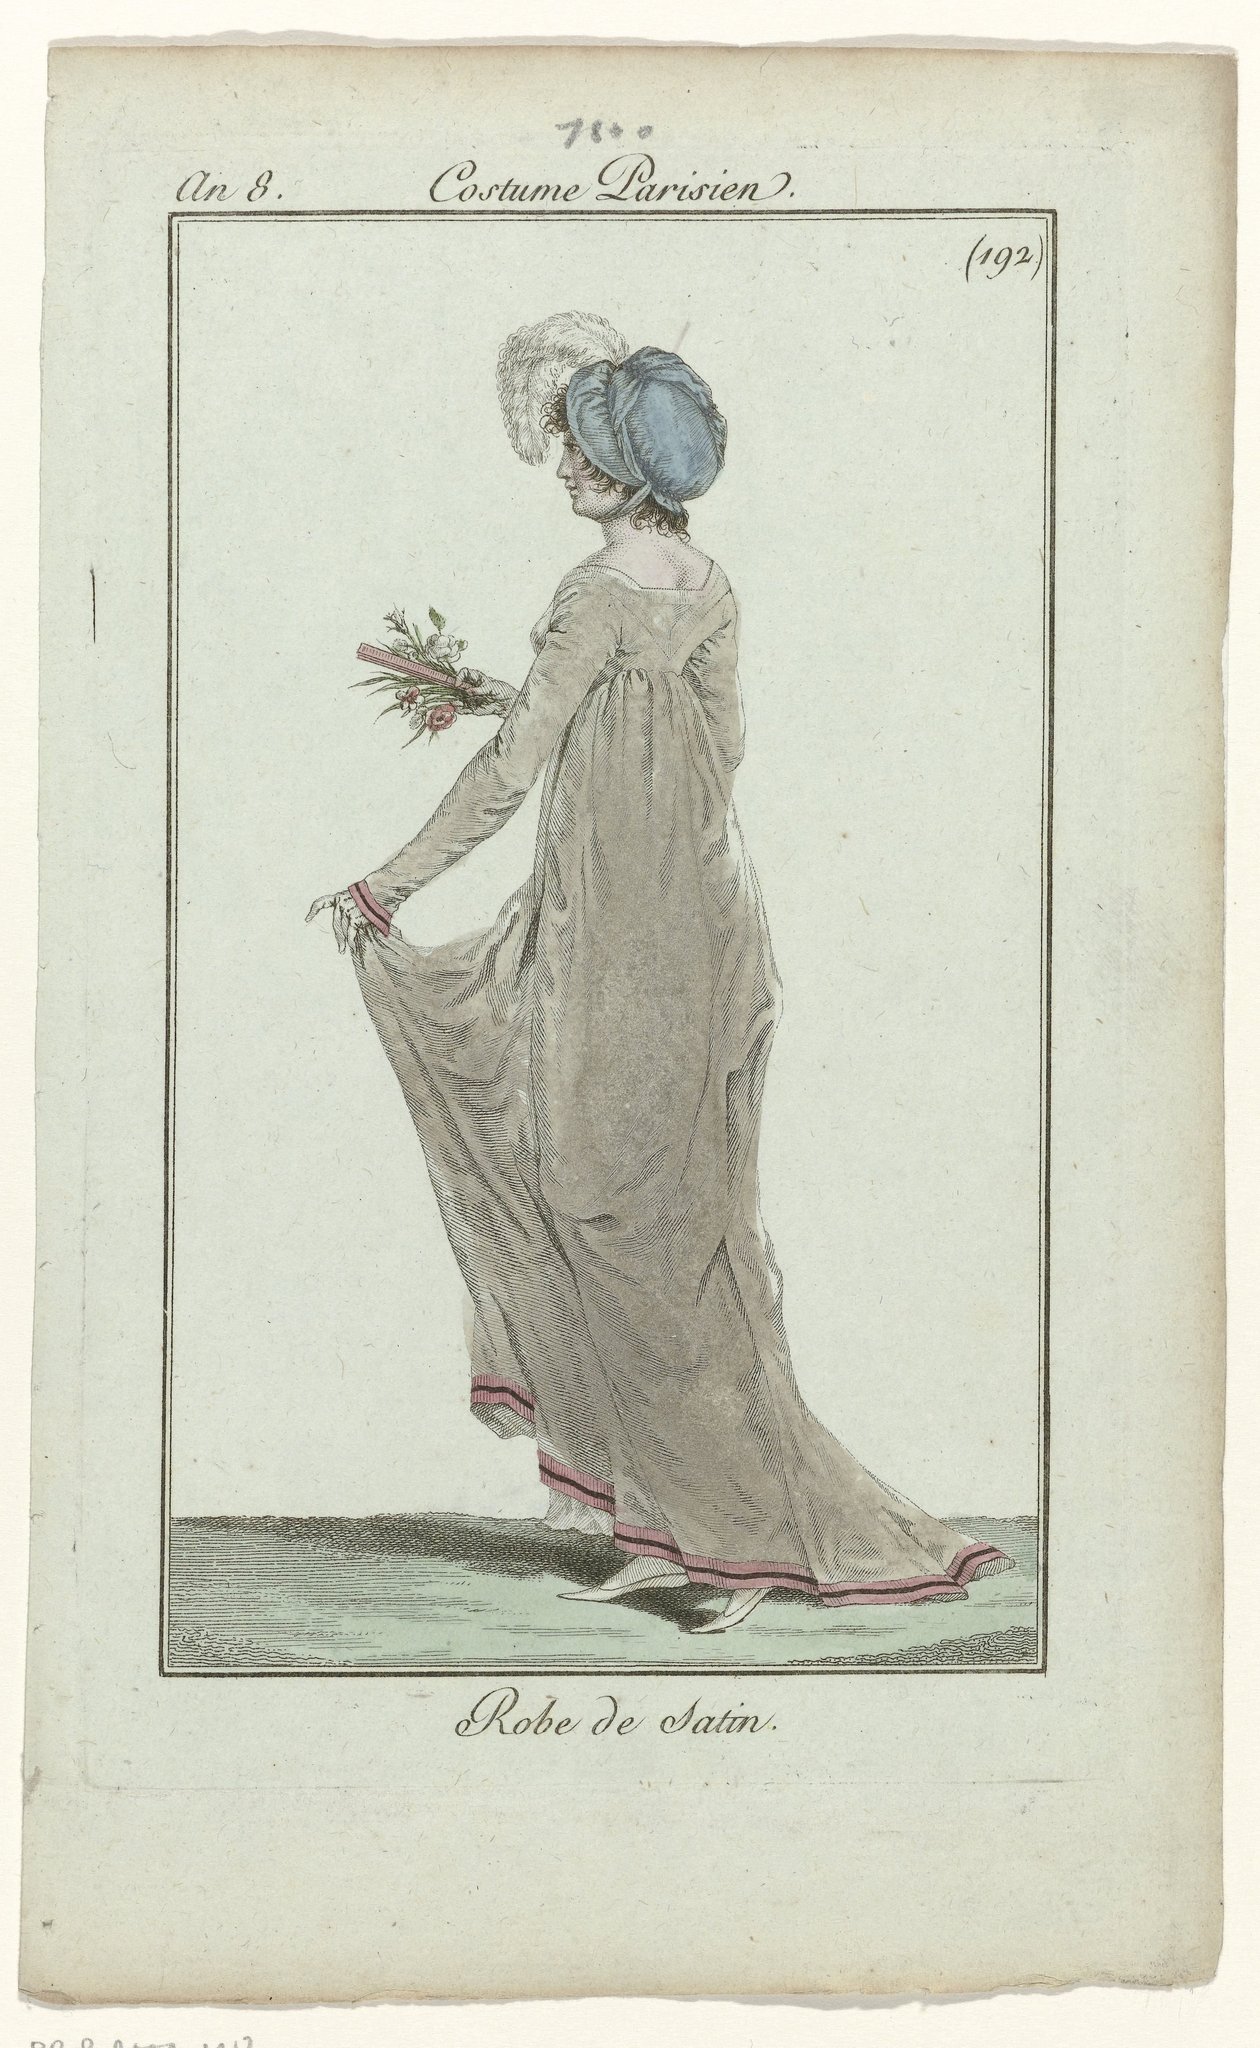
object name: fashion print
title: Journal des Dames et des Modes, Costume Parisien, 4 février 1800, An 8 (192) : Robe de satin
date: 1800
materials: paper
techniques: engraving, hand coloring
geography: paris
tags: cut flowers; nosegay, bunch of flowers, gloves, mittens (long gloves) (+ women's clothes), head-gear (+ women's clothes), fashion plates, shoes, sandals (+ women's clothes), dress, gown (+ women's clothes), fan (+ women's clothes)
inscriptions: caption: ‘Robe de satin’, title: ‘Costume Parisien.’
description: Japon van satijn; lange mouwen en sleep afgezet met gestreept sierband. Accessoires: hoed met struisveer, waaier, handschoenen, platte schoenen met puntige neuzen. De prent maakt deel uit van het modetijdschrift Journal des Dames et des Modes, uitgegeven door Pierre de la Mésangère, Parijs, 1797-1839.